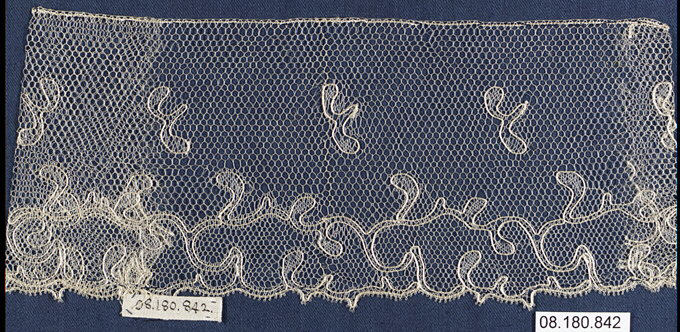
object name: fragment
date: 1801-1900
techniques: lace